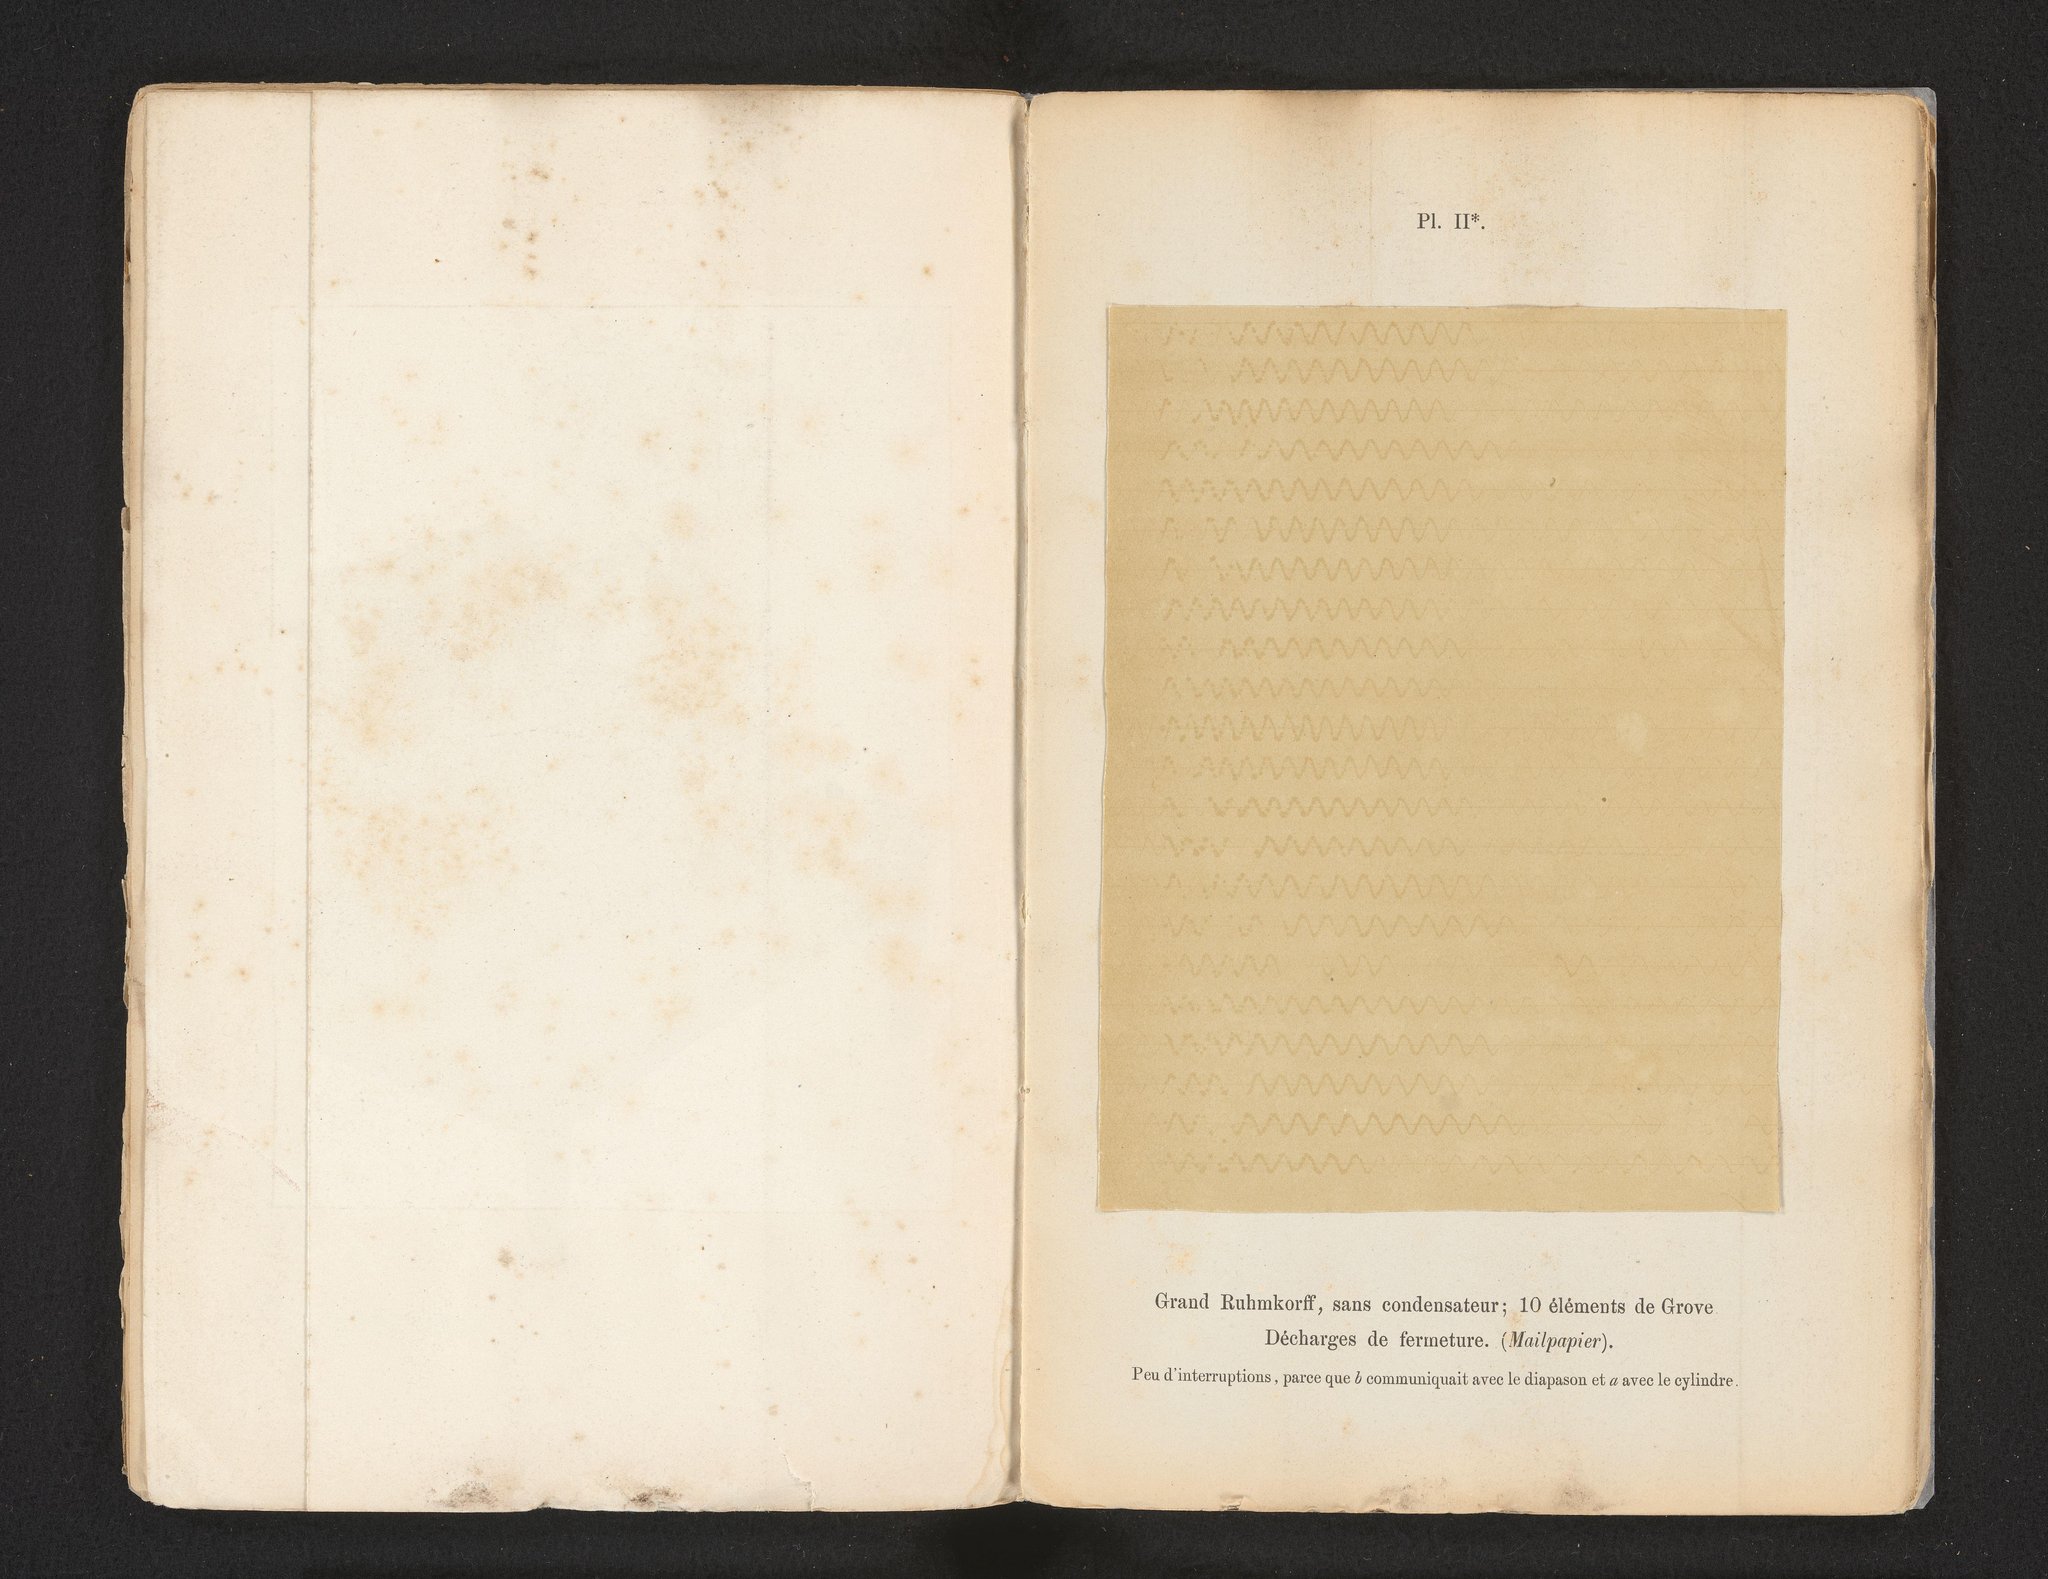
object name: page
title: Grand Ruhmkorff, sans condensateur; 10 elements de Grove, Decharges de fermeture (Mailpapier)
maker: willem cornelis van dijk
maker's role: painter, print maker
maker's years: 1826-1881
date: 1865-1870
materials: paper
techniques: albumen print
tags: electrical phenomena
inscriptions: number: ‘Pl. 11*.’, inscription: ‘Peu d'interruptions, parce que b communiquait avec le diapason et a avec le cylindre.’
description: Foto op derde ongenummerde pagina na pagina 368.